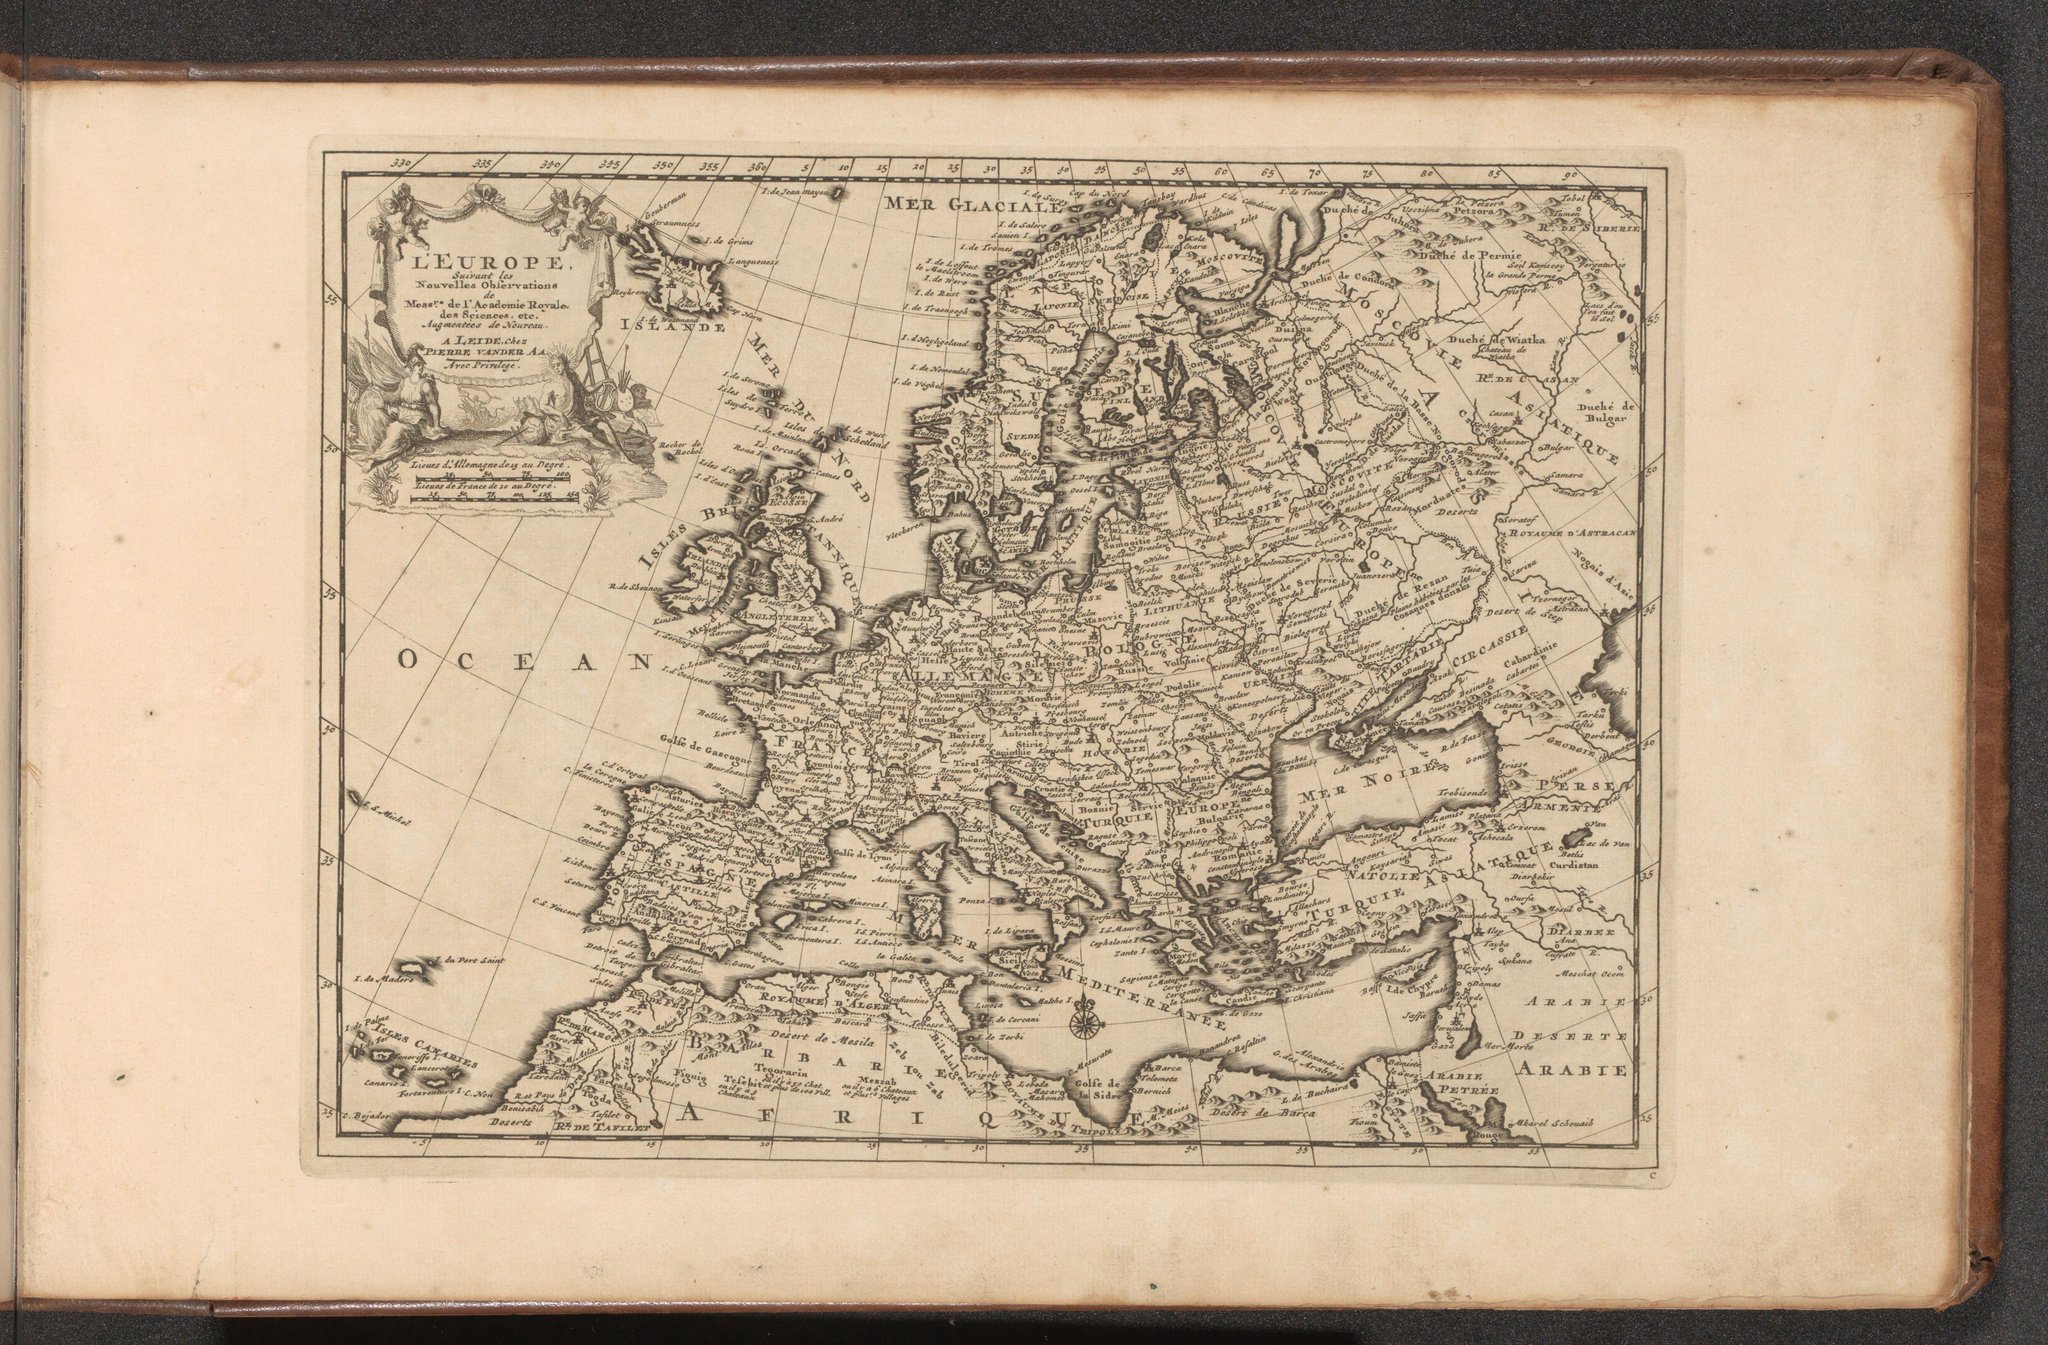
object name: print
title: l'Europe suivant les nouvelles observations de Mess[ieu]rs de l'Academie Royale des Sciences, etc. Augmentées de Nouveau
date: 1669-1733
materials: paper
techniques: etching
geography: leiden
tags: jupiter, usually in the shape of a white bull, abducts europa and carries her across the water, (story of) apollo (phoebus), (story of) minerva (pallas, athena), serpent ouroboros, europe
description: Kaart van Europa. Linksboven een cartouche geflankeerd door Minerva en Apollo als god van de kunsten. Eronder de roof van Europa door Jupiter in de gedaante van een stier. Rechtsonder: c. De prent maakt deel uit van een album.